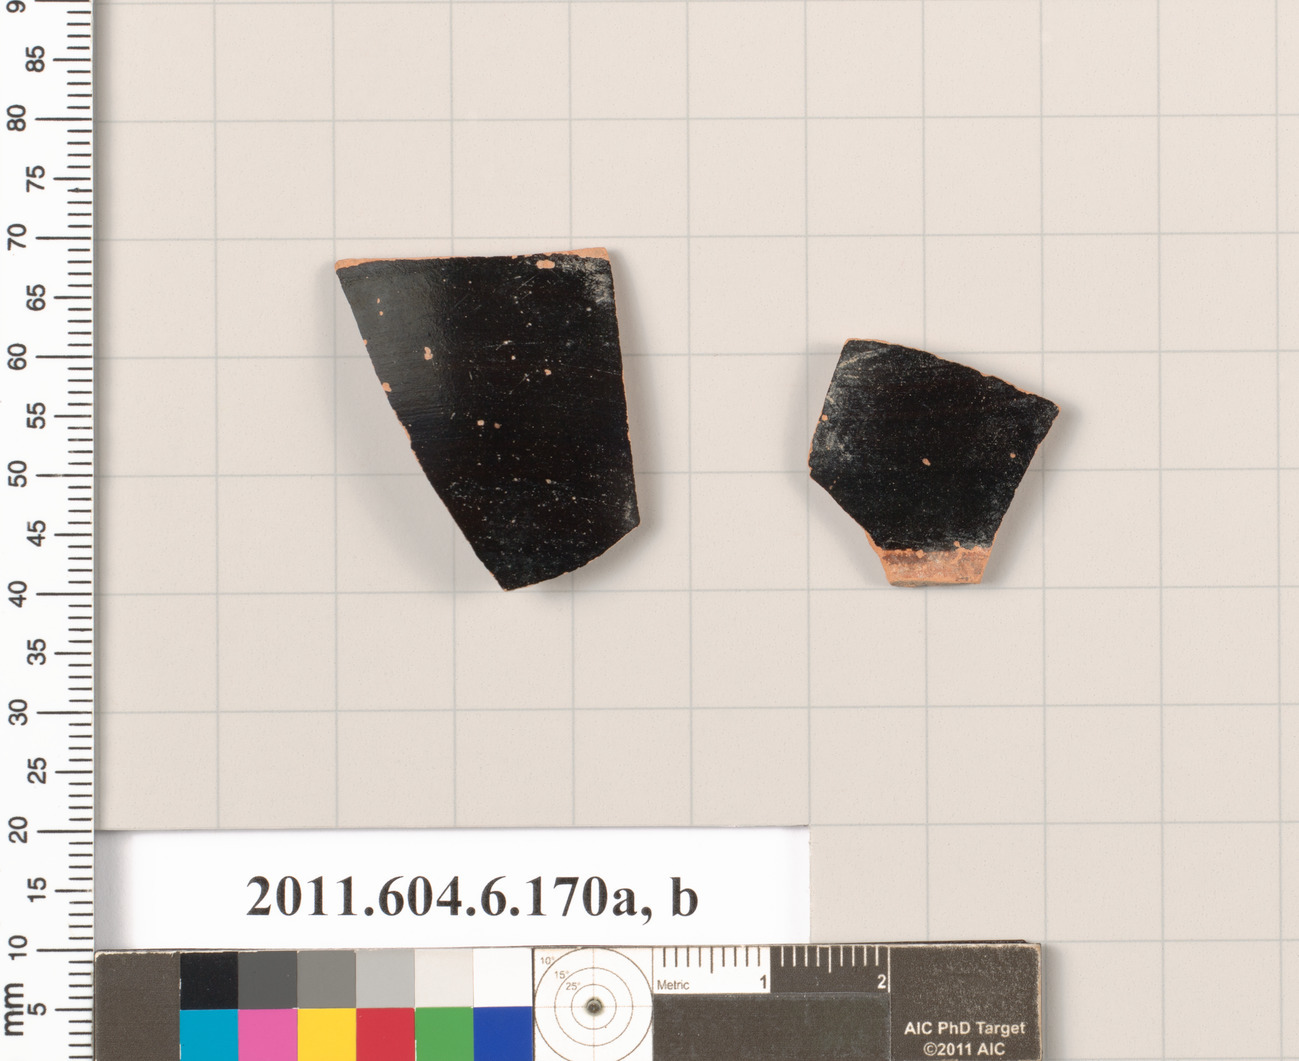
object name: undetermined shape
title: Terracotta fragments of an undetermined shape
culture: greek, attic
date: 600-401 BCE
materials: terracotta